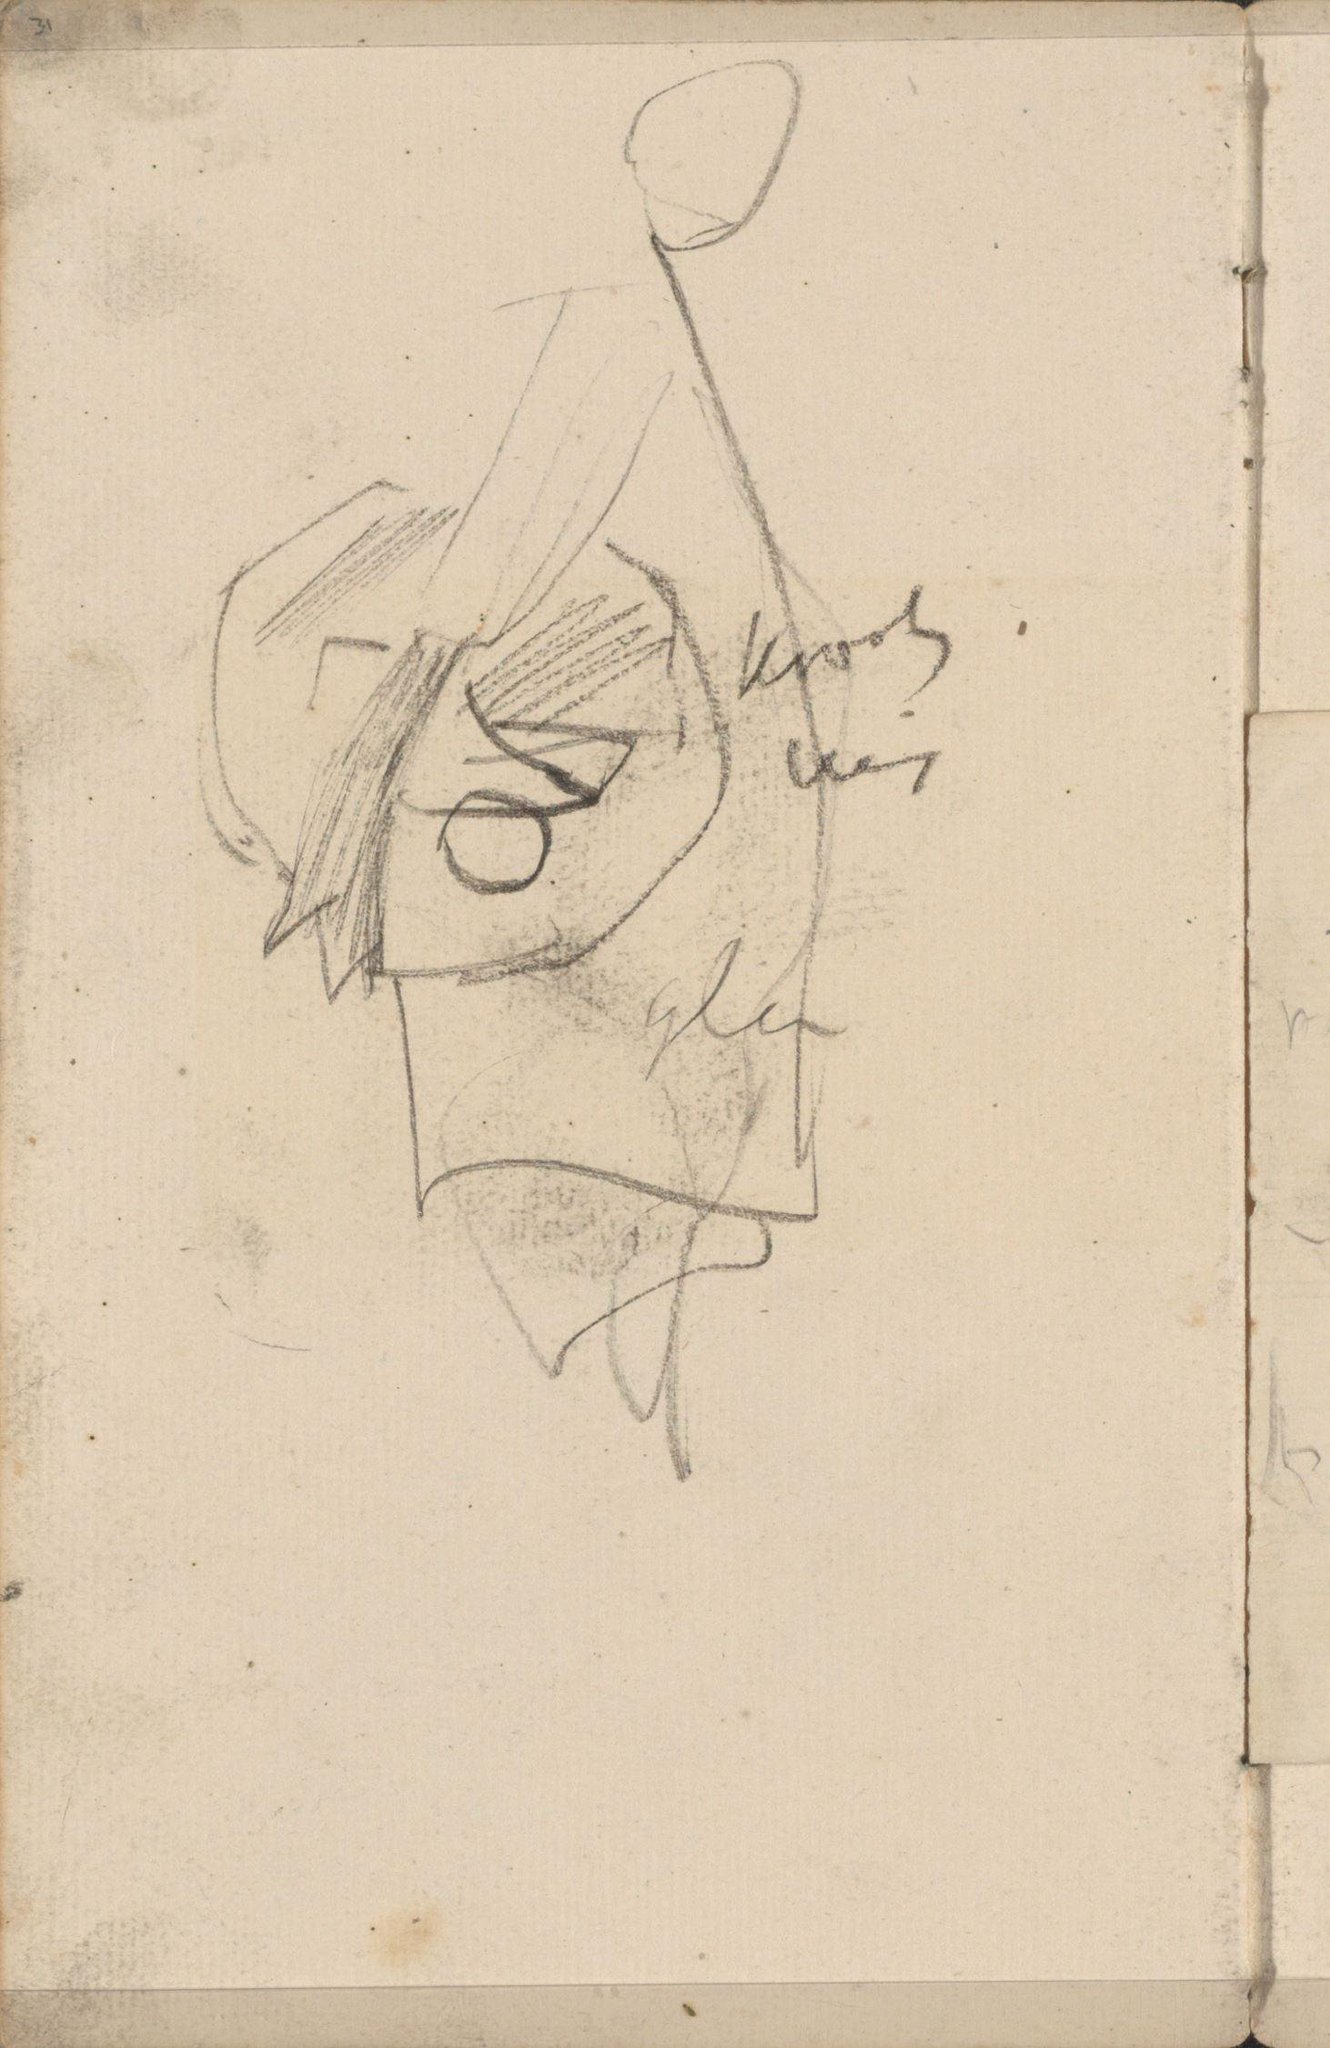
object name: sketchbook leaf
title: Studie, mogelijk van een vrouw met een voorwerp onder haar arm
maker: george hendrik breitner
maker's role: draughtsman, painter, print maker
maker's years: 1857-1923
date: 1884-1886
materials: chalk, paper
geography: the hague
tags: adult woman, carrying something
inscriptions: kleurnotitie, handgeschreven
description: Pagina 31 uit een schetsboek met 29 bladen.